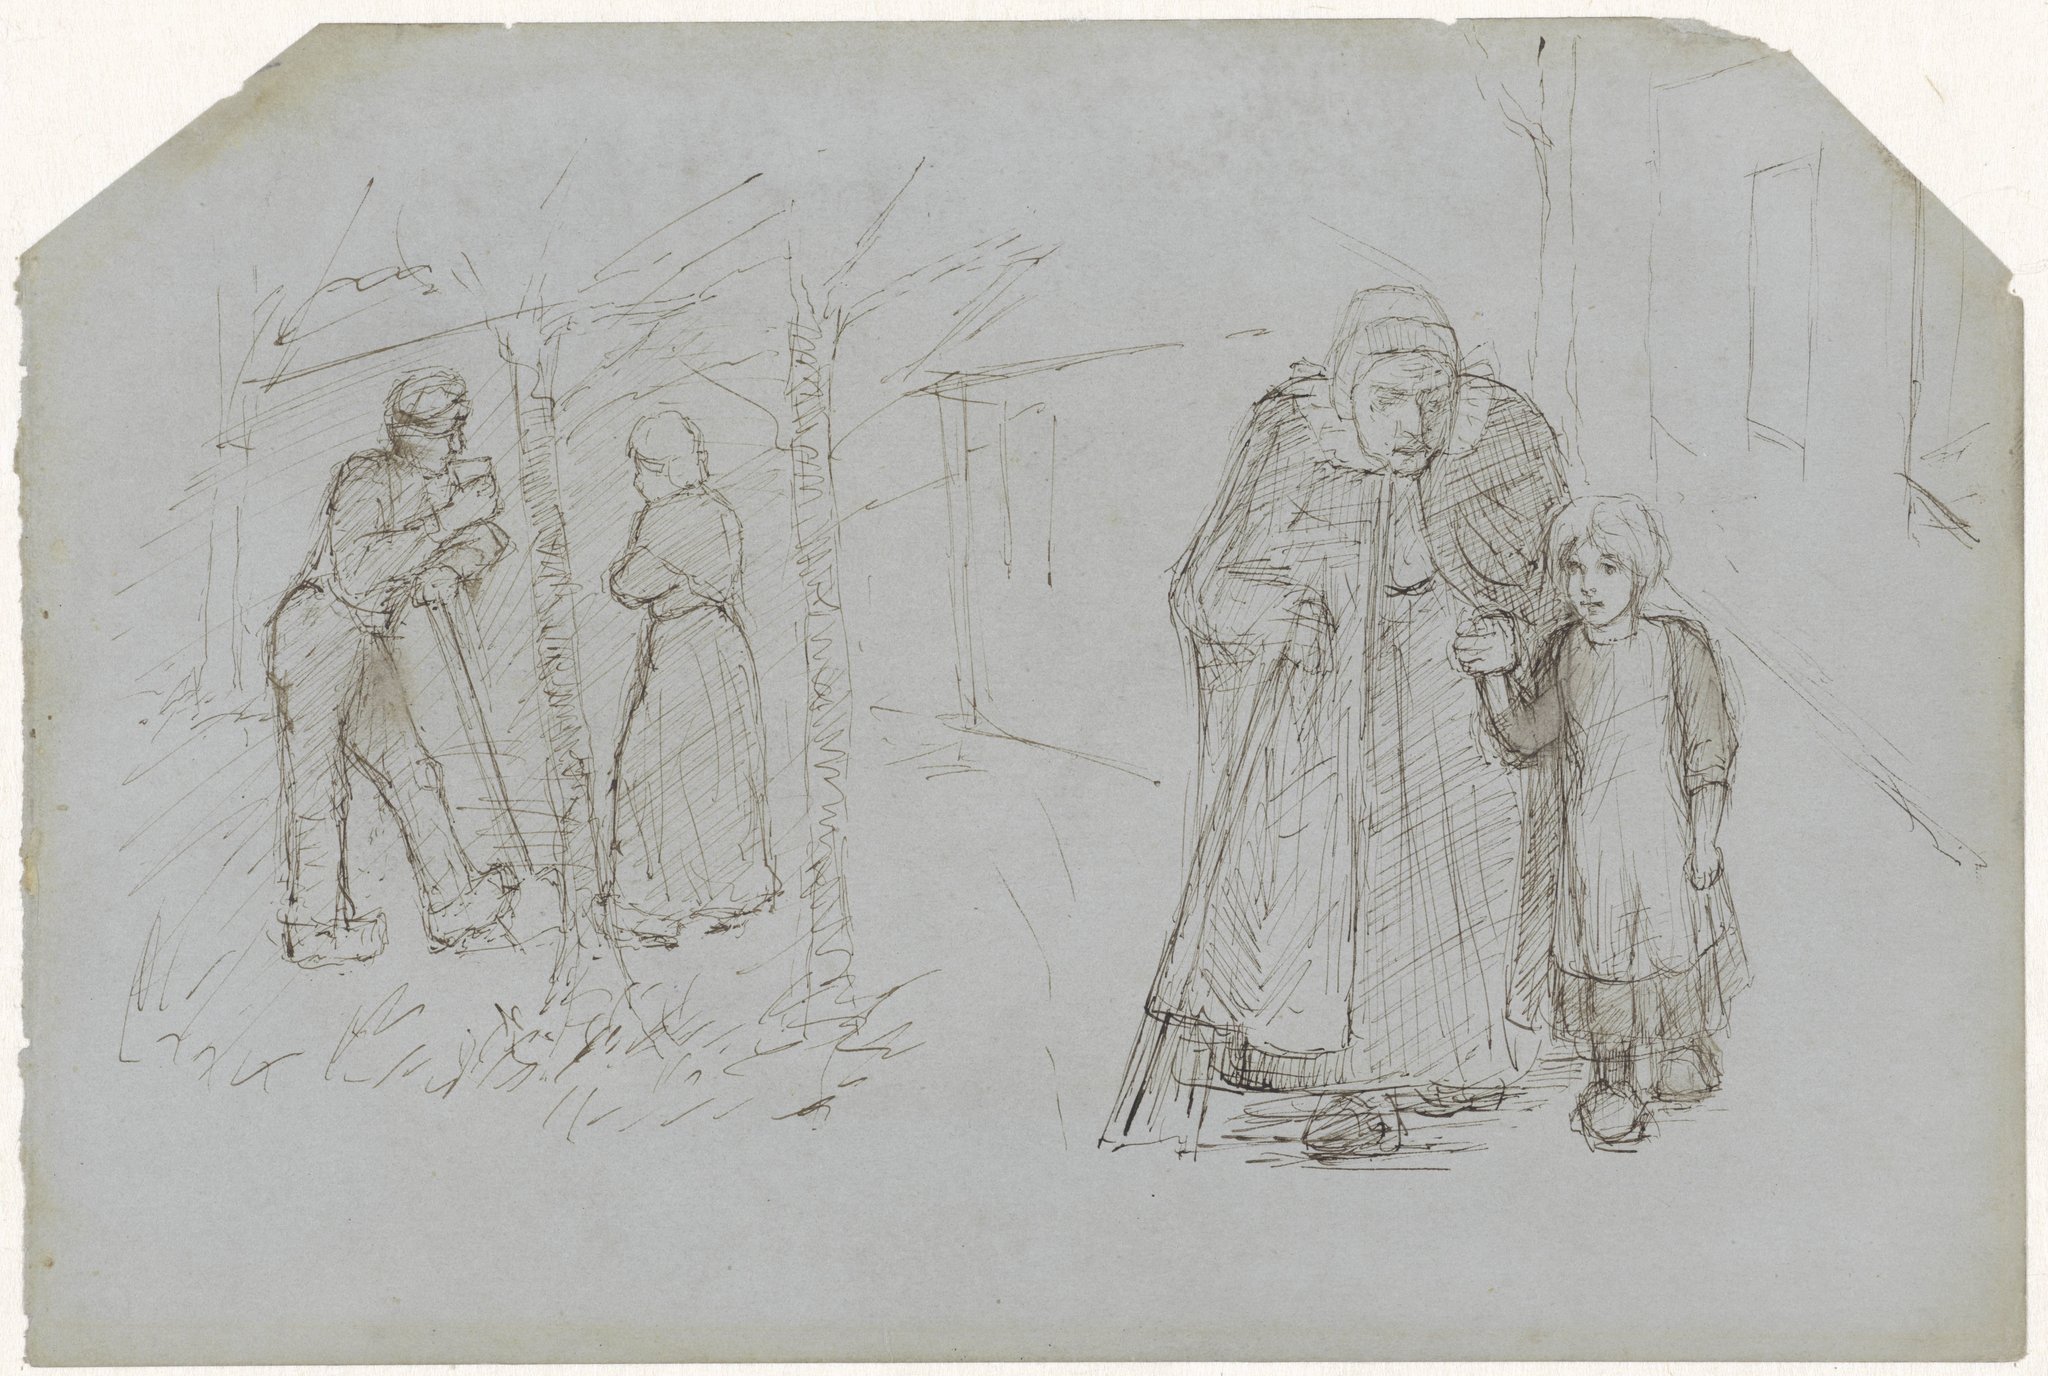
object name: drawing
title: Boer, boerin en meisje met een oude vrouw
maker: jozef israëls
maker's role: draughtsman, painter, print maker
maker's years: 1824-1911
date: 1834-1911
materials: ink, paper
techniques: pen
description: Drinkende boer en boerin tussen de bomen en meisje met een oude vrouw.